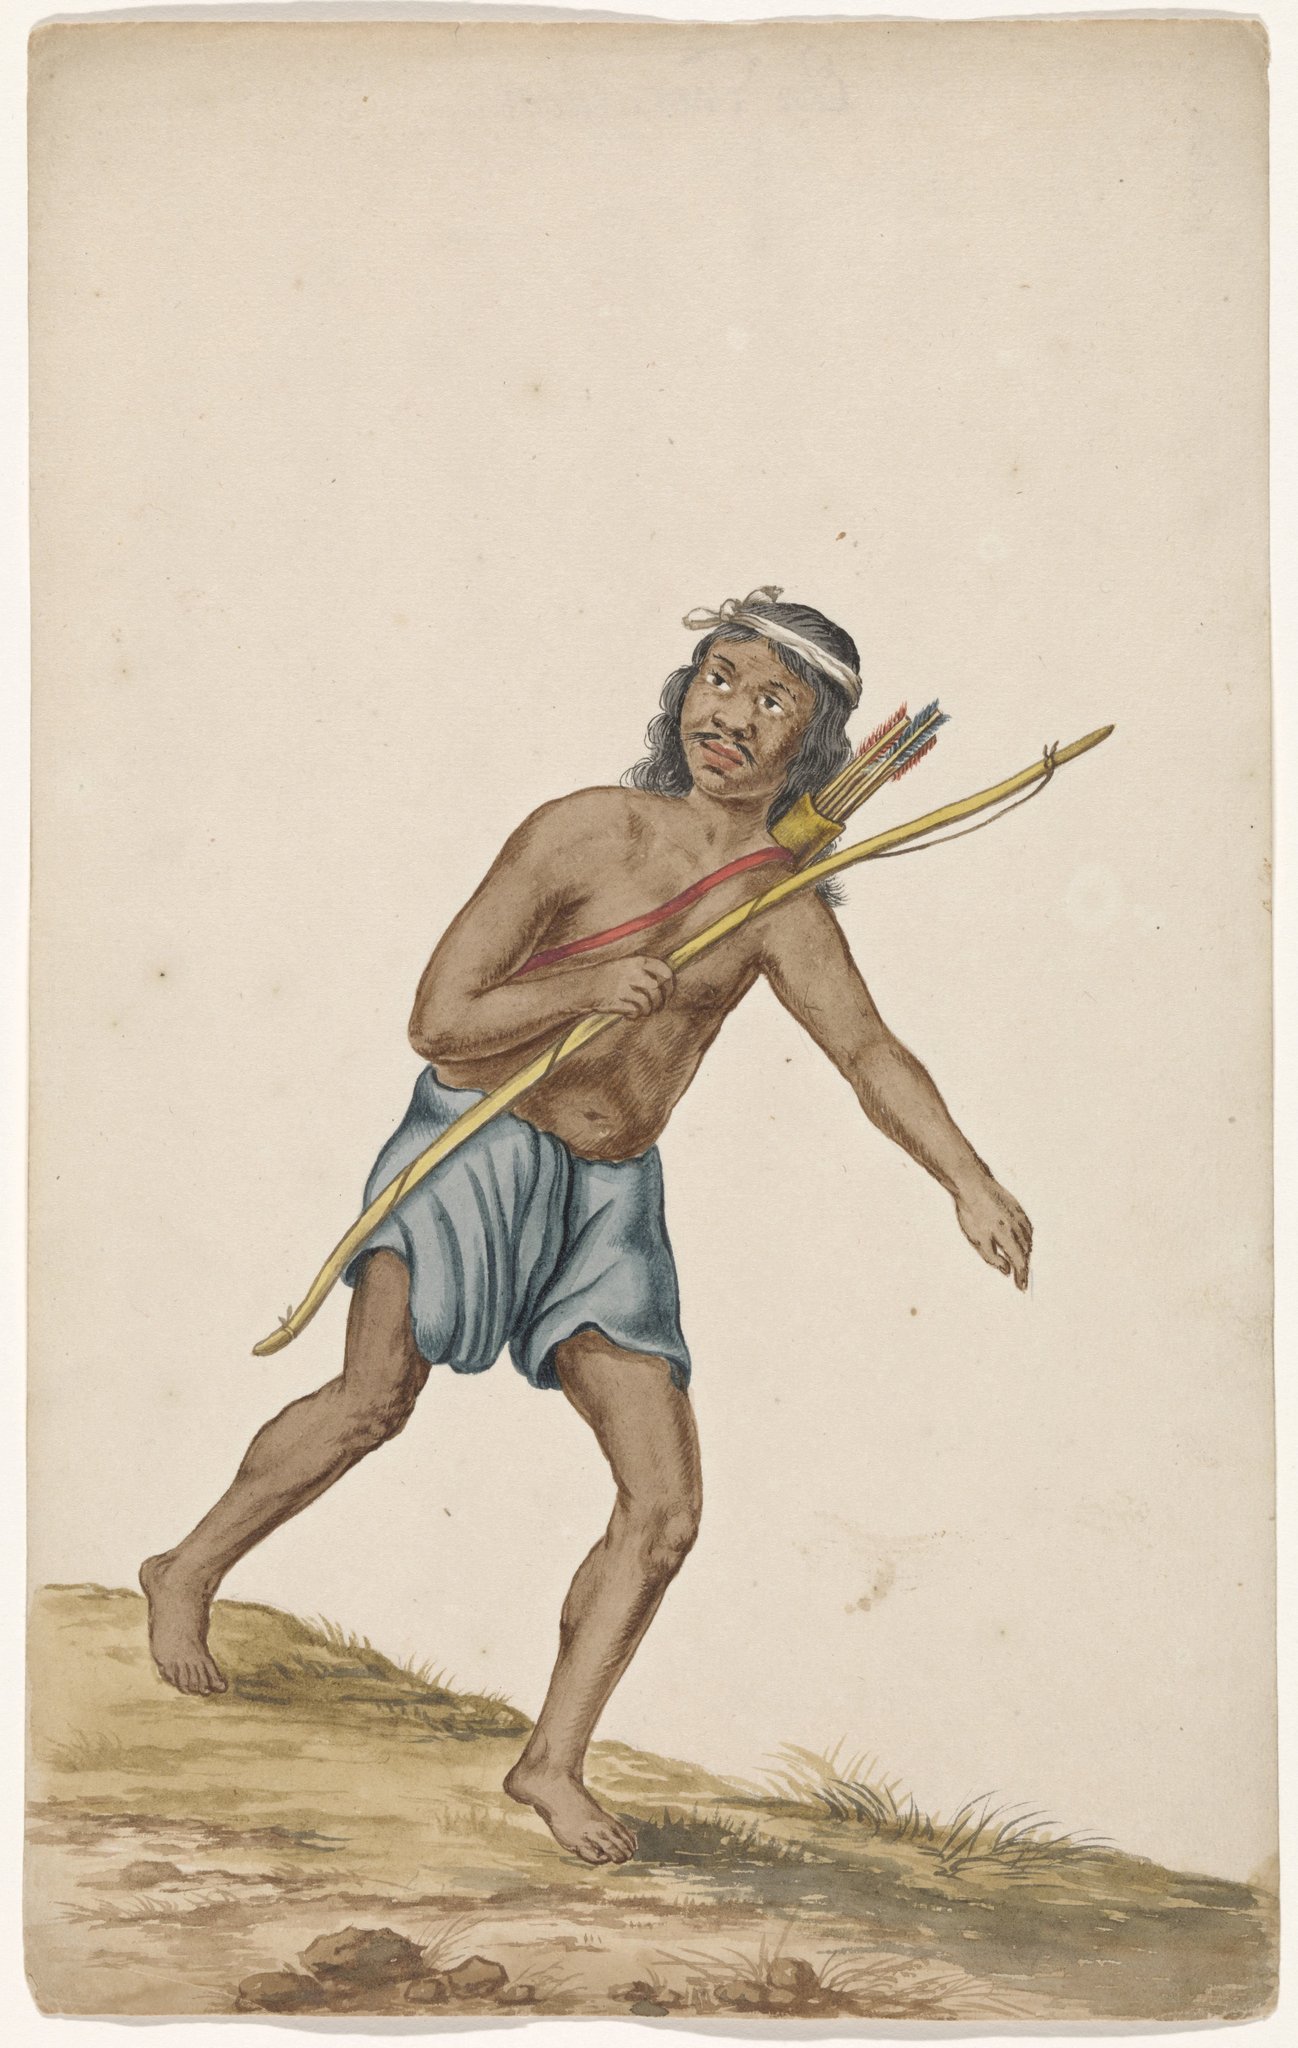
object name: drawing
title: A Warrior from Ternate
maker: Anonymous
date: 1675-1725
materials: paper, watercolor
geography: netherlands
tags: asiatic races and peoples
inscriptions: annotation: ‘Een Ternataan’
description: Man in blauwe lendedoek met witte haarband. In zijn rechterhand heeft hij een boog vast en over zijn schouder hangt een pijlenkoker met pijlen